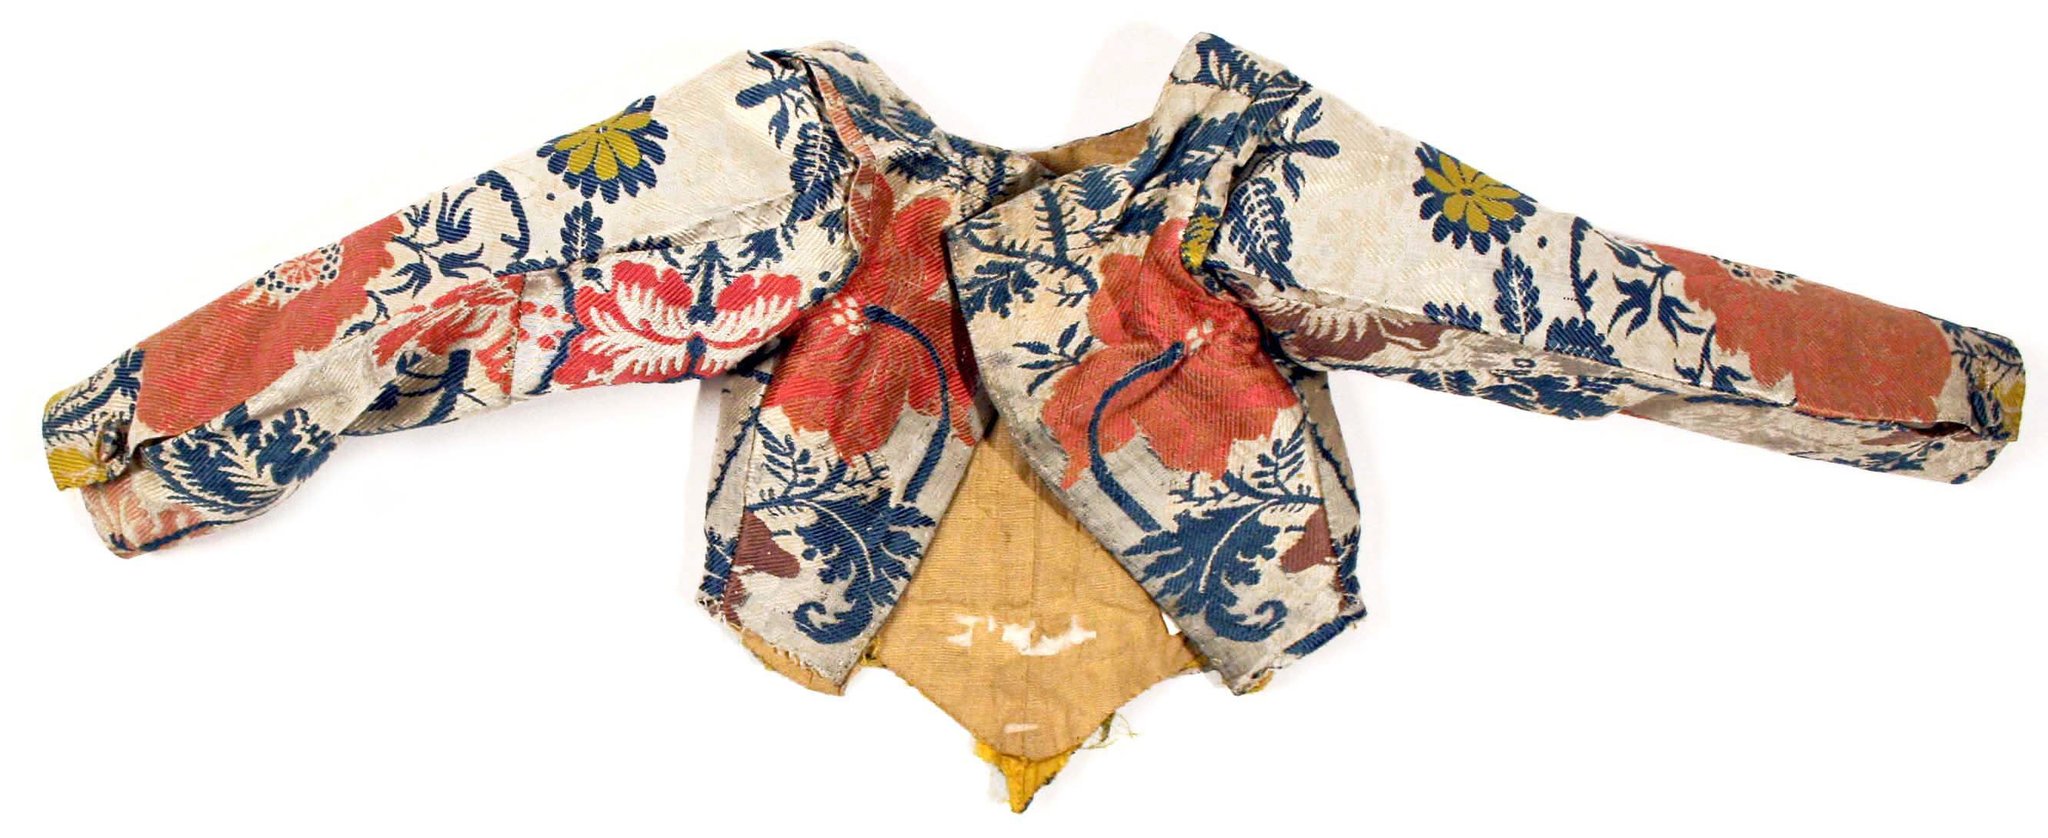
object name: doll accessory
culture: french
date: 1701-1800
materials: silk